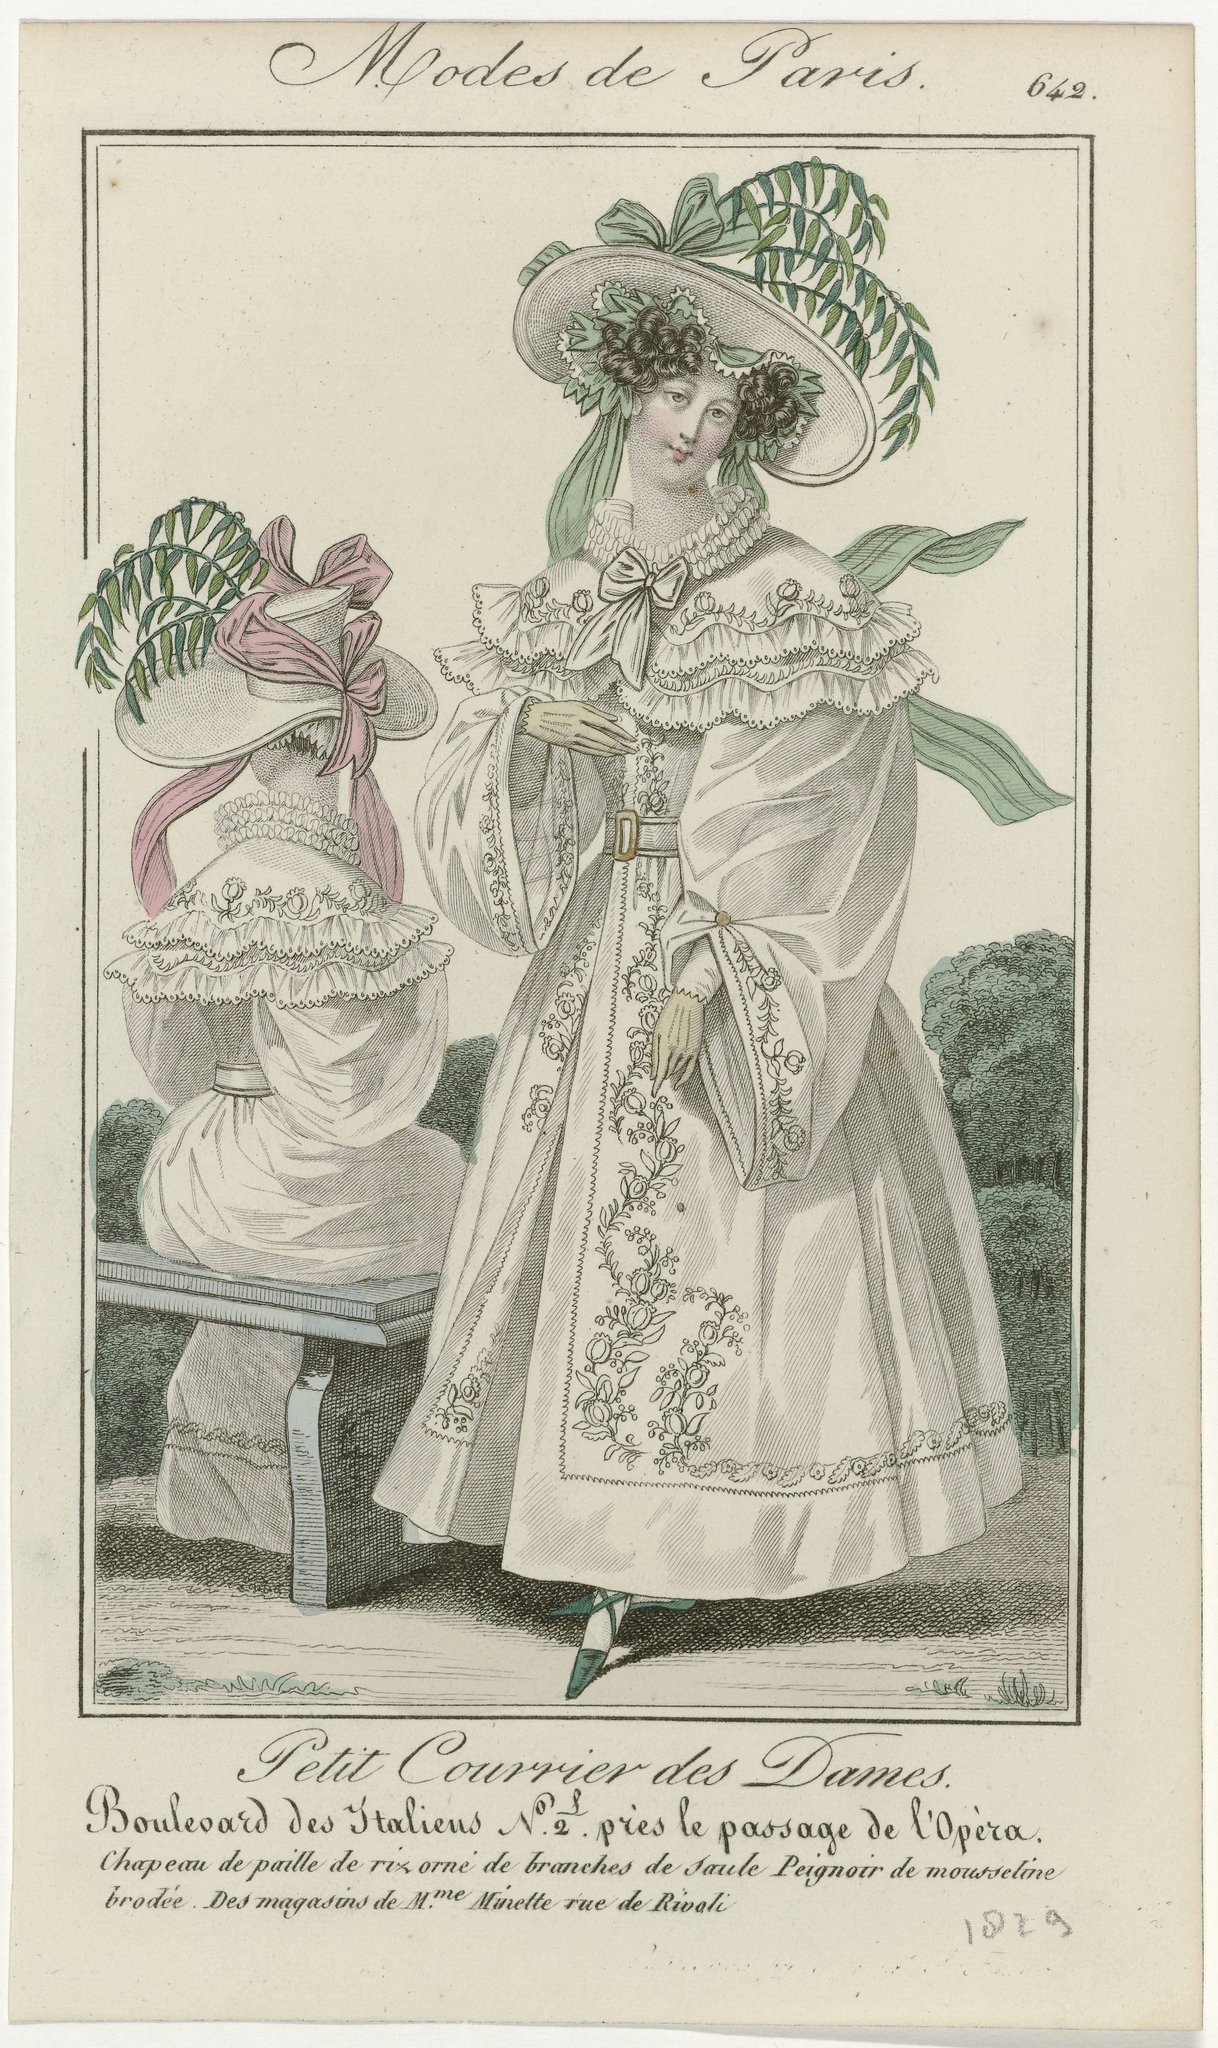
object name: fashion print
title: Petit Courrier des Dames, 1829, No. 642 : Chapeau de paille de riz..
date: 1829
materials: paper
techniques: engraving, hand coloring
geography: paris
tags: coat (housecoat) (+ women's clothes), fashion plates, head-gear: hat (+ women's clothes), gloves, mittens, etc. (+ women's clothes), neck-gear ~ clothing (+ women's clothes), belt, girdle, waistband (+ women's clothes)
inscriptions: title: ‘Petit Courrier des Dames.’, caption: ‘Chapeau de paille de riz orné de branches de saule Peignoir de mousseline brodée. des magasins de M.me Minette rue de Rivoli.’, address: ‘Boulevard des Italiens No.2 près le passage de l'Opèra.’, title: ‘Modes de Paris.’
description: Hoed van 'paille de riz', versierd met wilgentakken. 'Peignoir' van geborduurde mousseline, uit de winkels van Minette. Verdere accessoires: handschoenen, ceintuur met gesp, platte schoenen met gekruiste banden. Prent uit het modetijdschrift Petit Courrier des Dames (1821-1868).